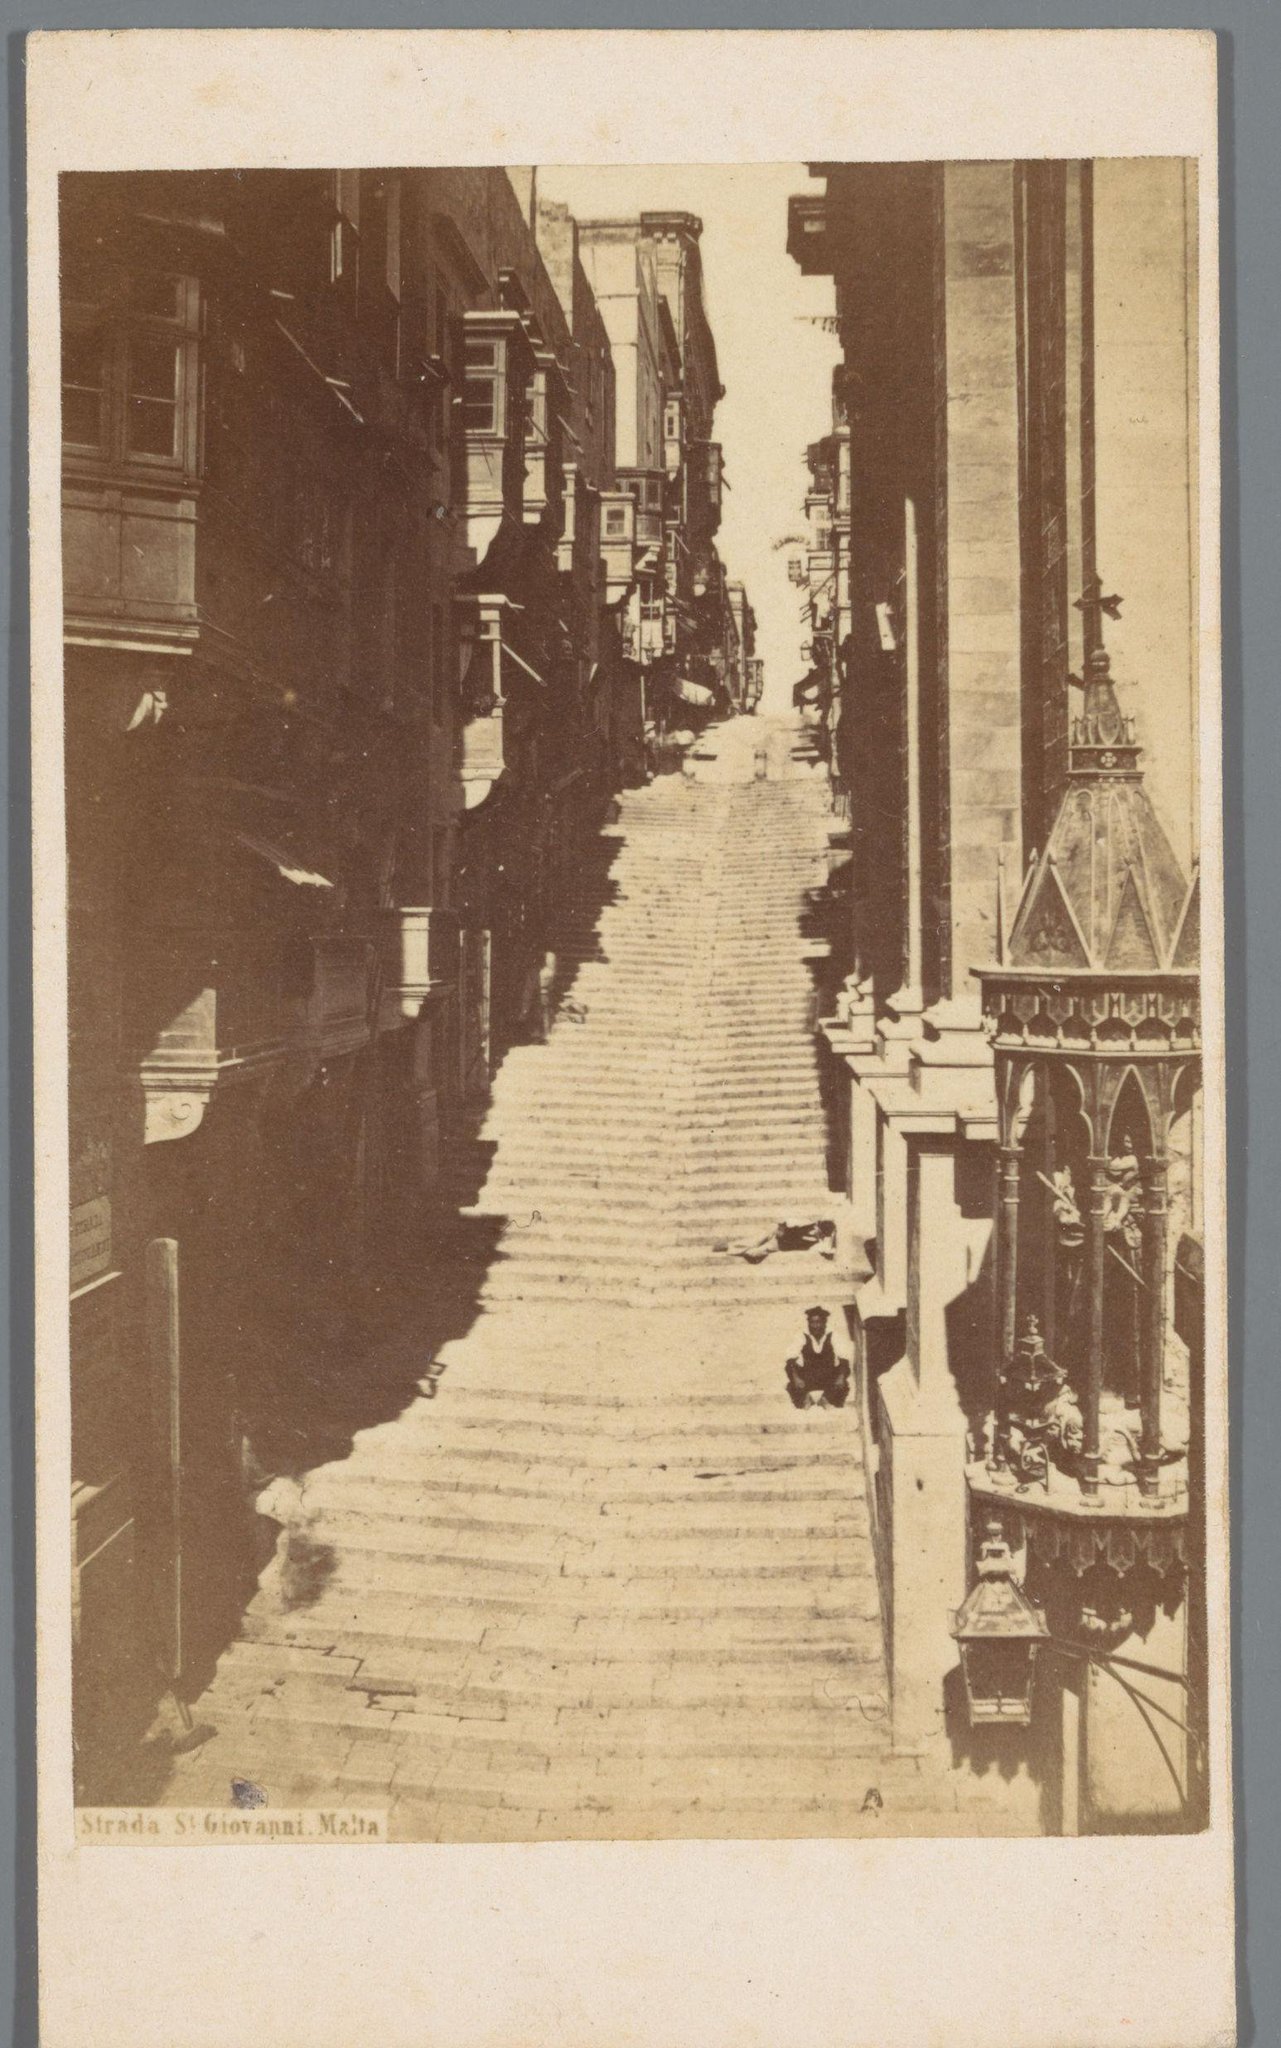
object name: carte de visite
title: Strada St. Giovanni, Valletta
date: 1859-1874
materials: cardboard, paper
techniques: albumen print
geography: valletta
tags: sloping street; street with steps or stairs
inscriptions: inscription: ‘Malta’